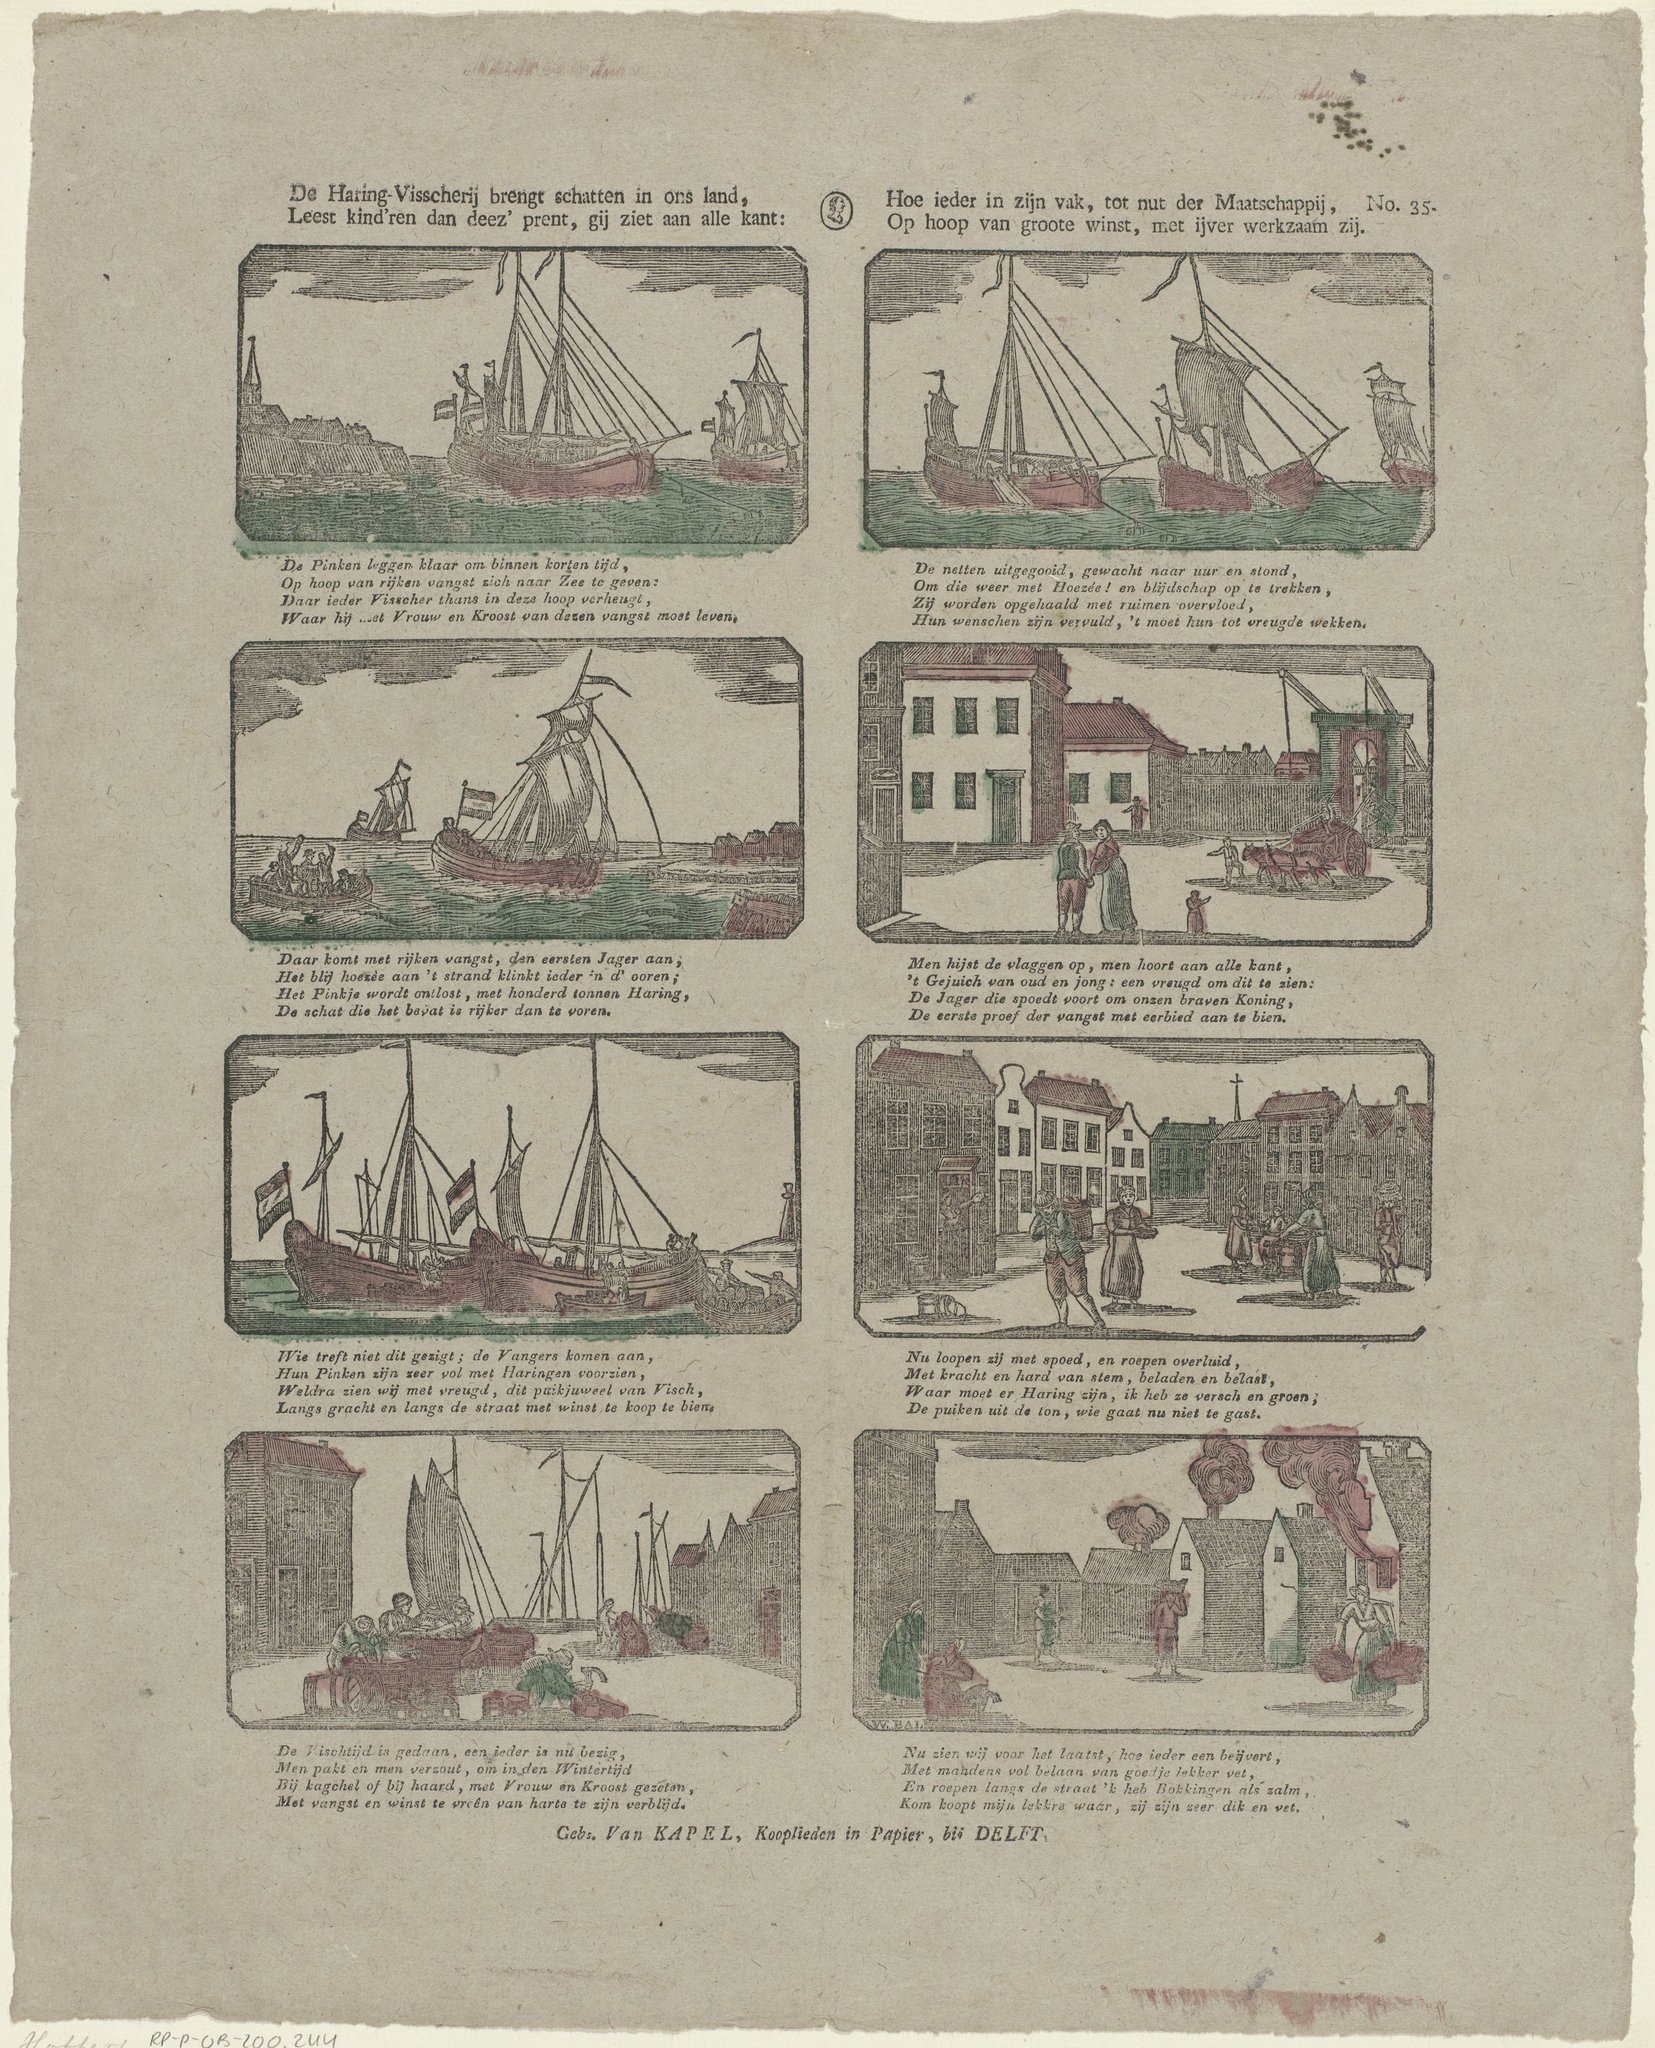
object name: print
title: De haring-visscherij brengt schatten in ons land, / Leest kind'ren dan deez' prent, gij ziet aan alle kant: / Hoe ieder in zijn vak, tot nut der Maatschappij, / Op hoop van groote winst, met ijver werkzaam zij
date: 1820-1837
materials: paper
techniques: colour, letterpress printing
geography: rijswijk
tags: herring fishery, ships (in general)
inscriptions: collector's mark: Lugt 2760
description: Blad met 8 voorstellingen van de haringvisserij. Onder elke voorstelling een vierregelig vers. Genummerd rechtsboven: No. 35.